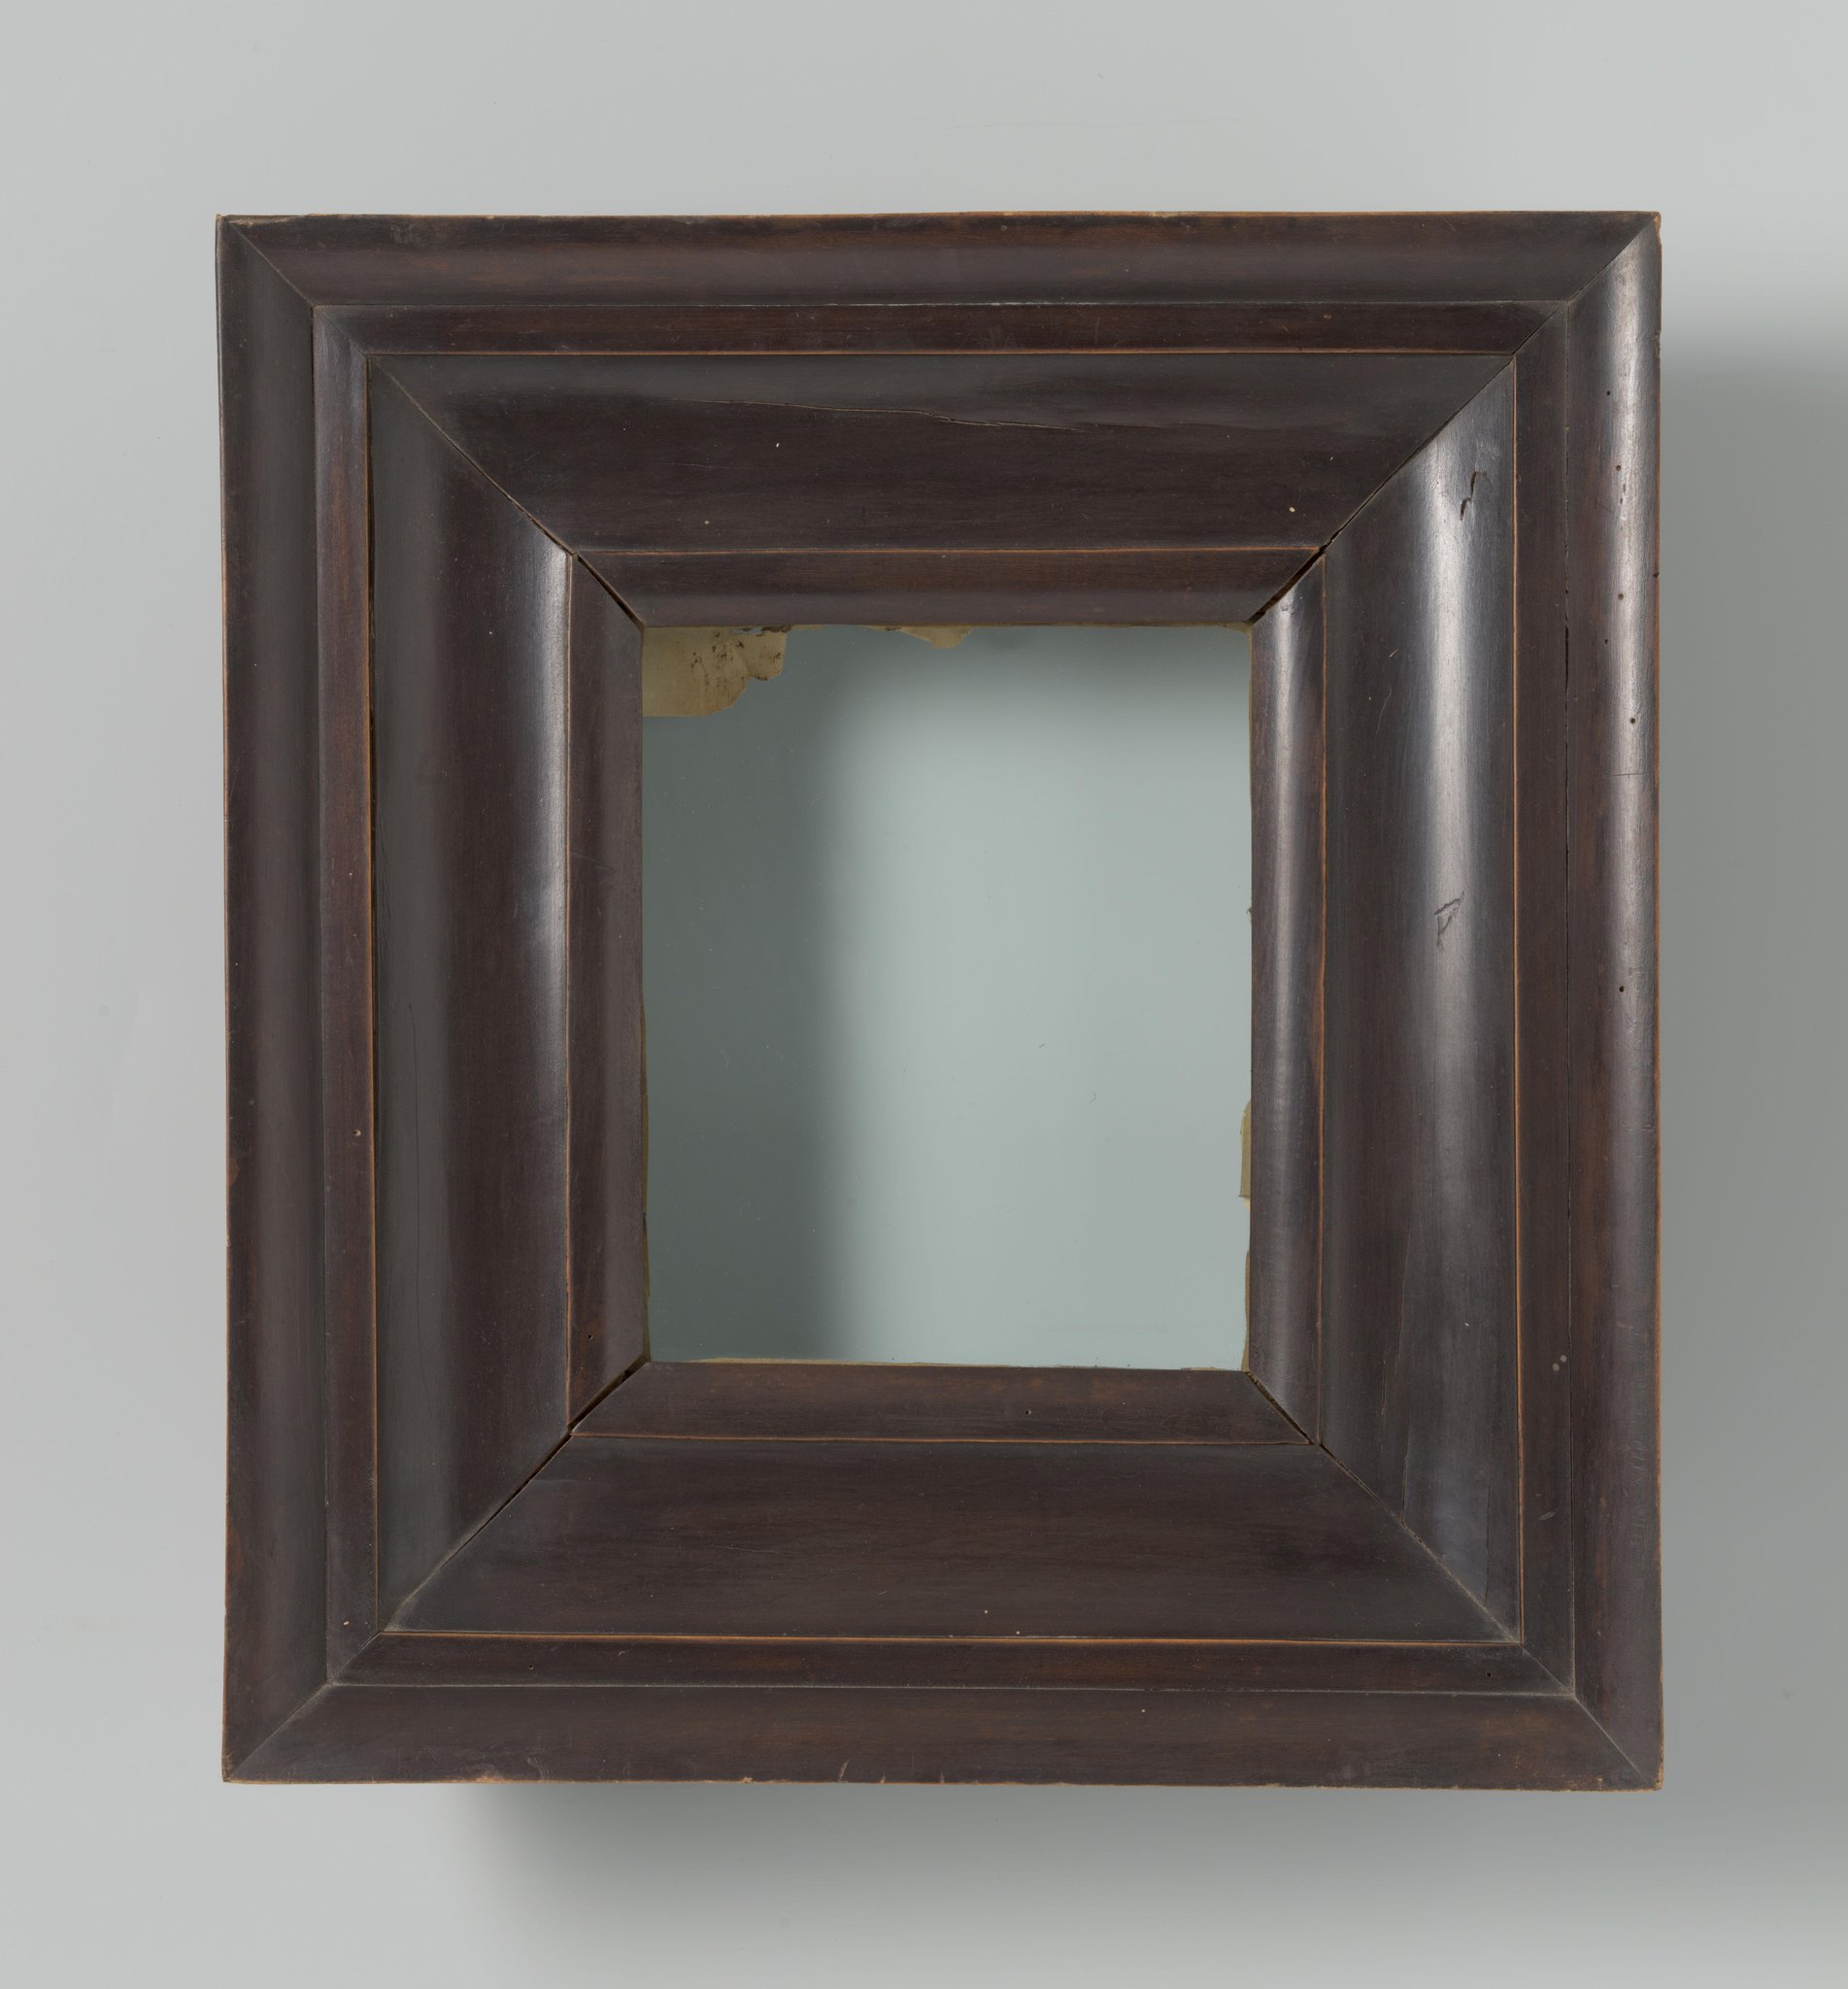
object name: frame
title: Zwarte holle profiellijst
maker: Anonymous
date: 1690-1699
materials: wood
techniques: veneering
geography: rotterdam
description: Holle, zwart gebeitste profiellijst. De kern is van naaldhout en het profiel is gefineerd met notenhout. Het profiel van de lijst bestaat uit vier onderdelen: een binnenrand met een flauwe bolling, een breed oplopend holle koof, een smallere holle koof, een vlakke trede, en tenslotte een brede licht oplopende bolle buitenrand. Aan de achterzijde heeft de lijst een houten opbouw, zodat de voor het knipsel benodigde diepte is verkregen, waartegen een houten achterplaat is bevestigd. De lijst heeft nog zijn originele houten ophangoog.